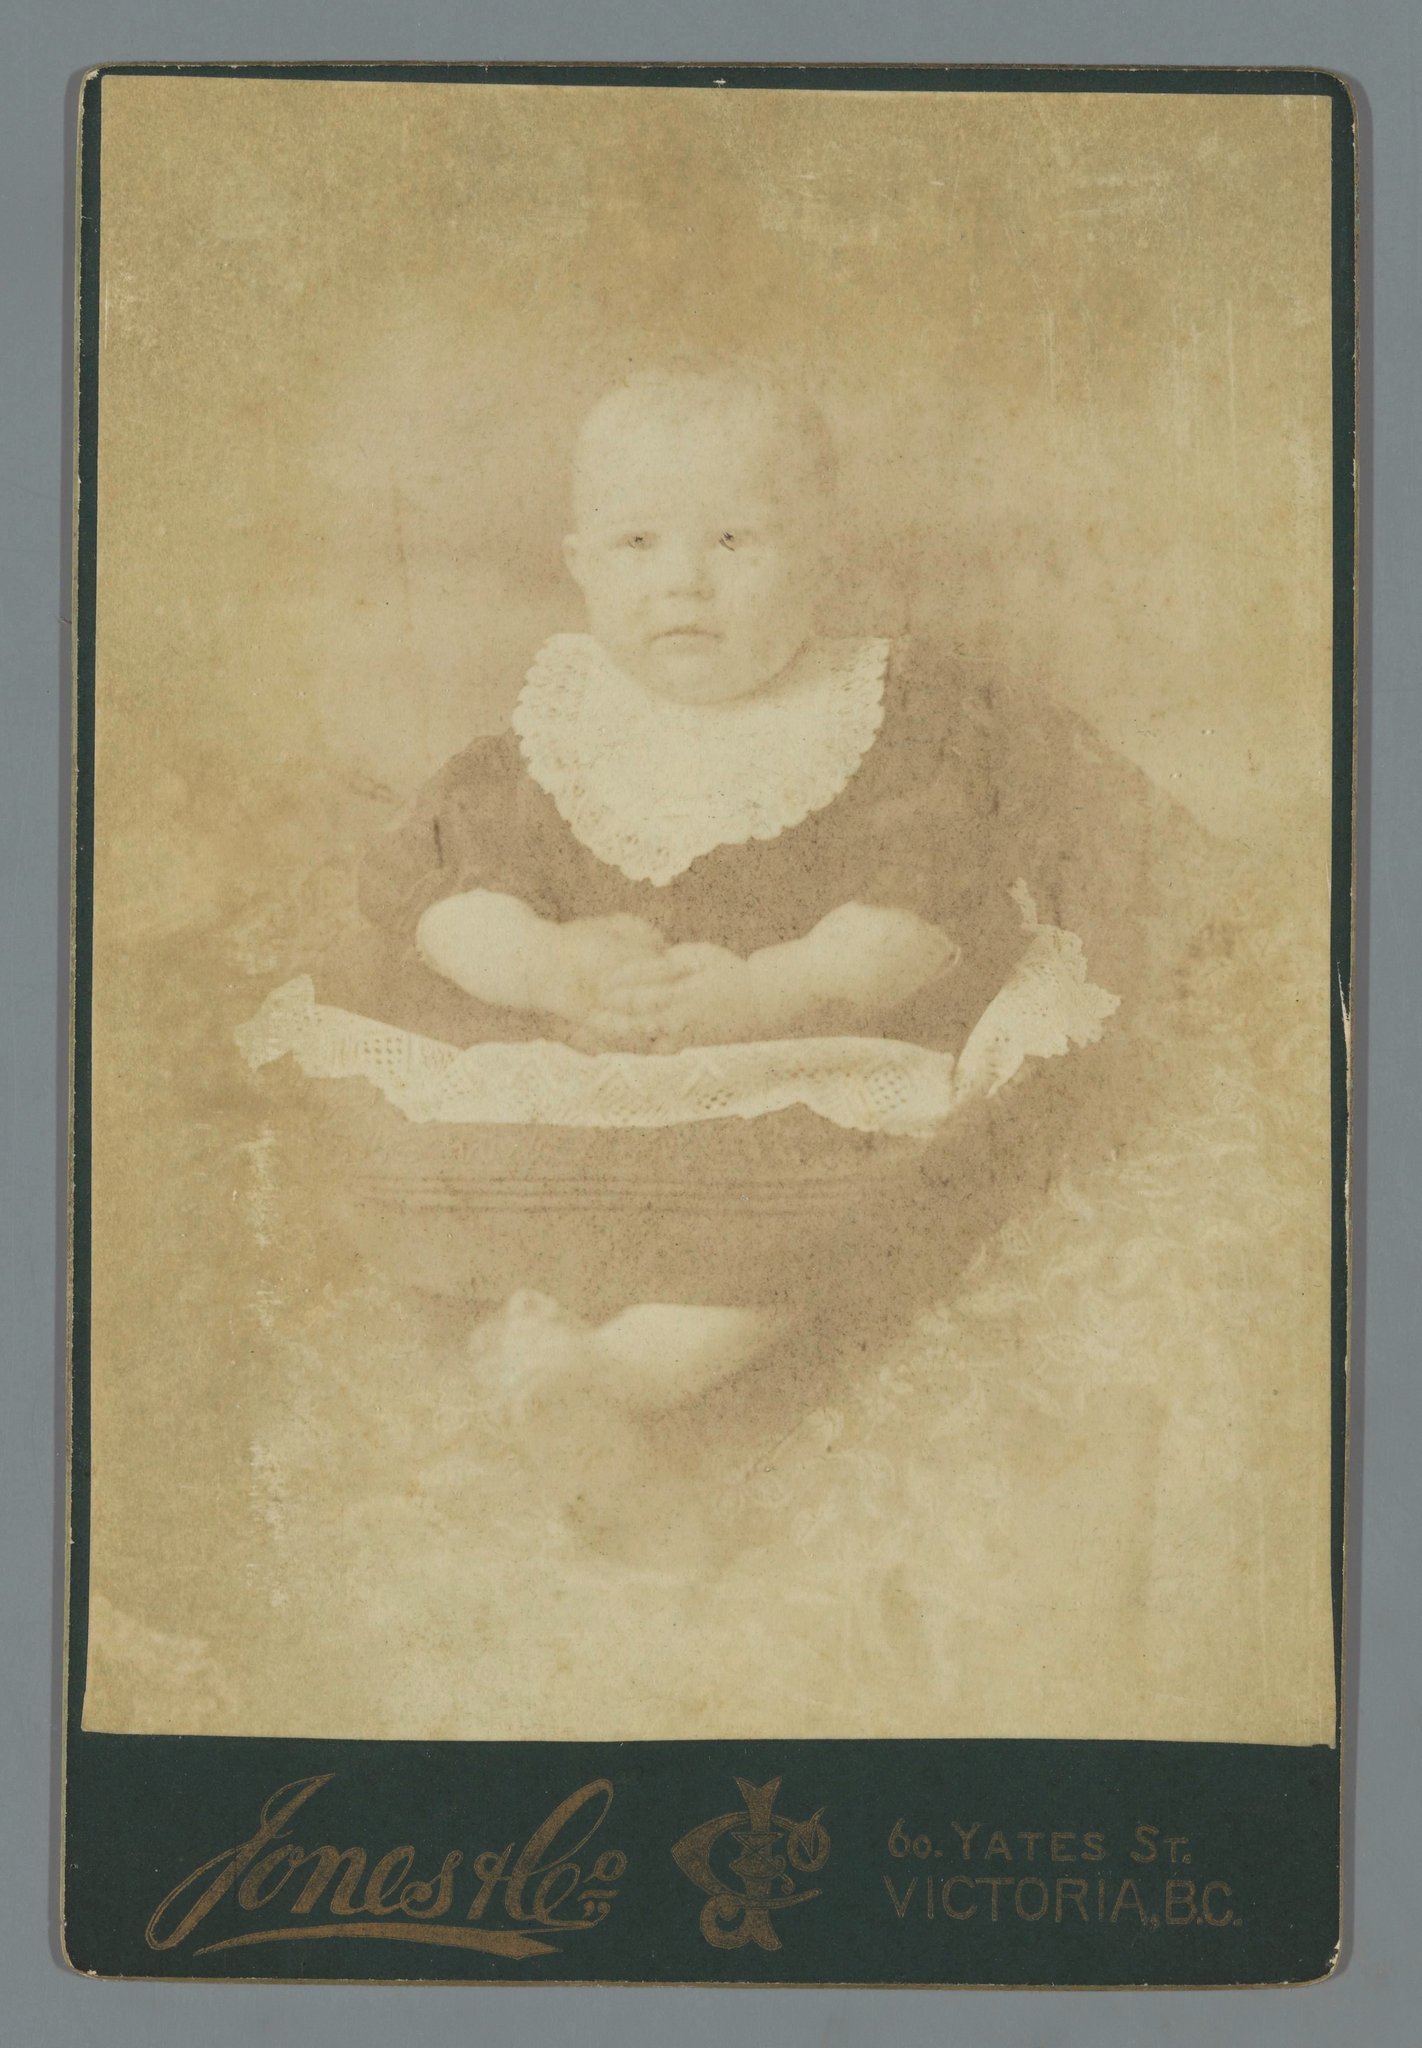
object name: cabinet photograph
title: Portret van een baby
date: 1870-1900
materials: cardboard, photographic support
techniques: albumen print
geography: canada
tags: infant, baby